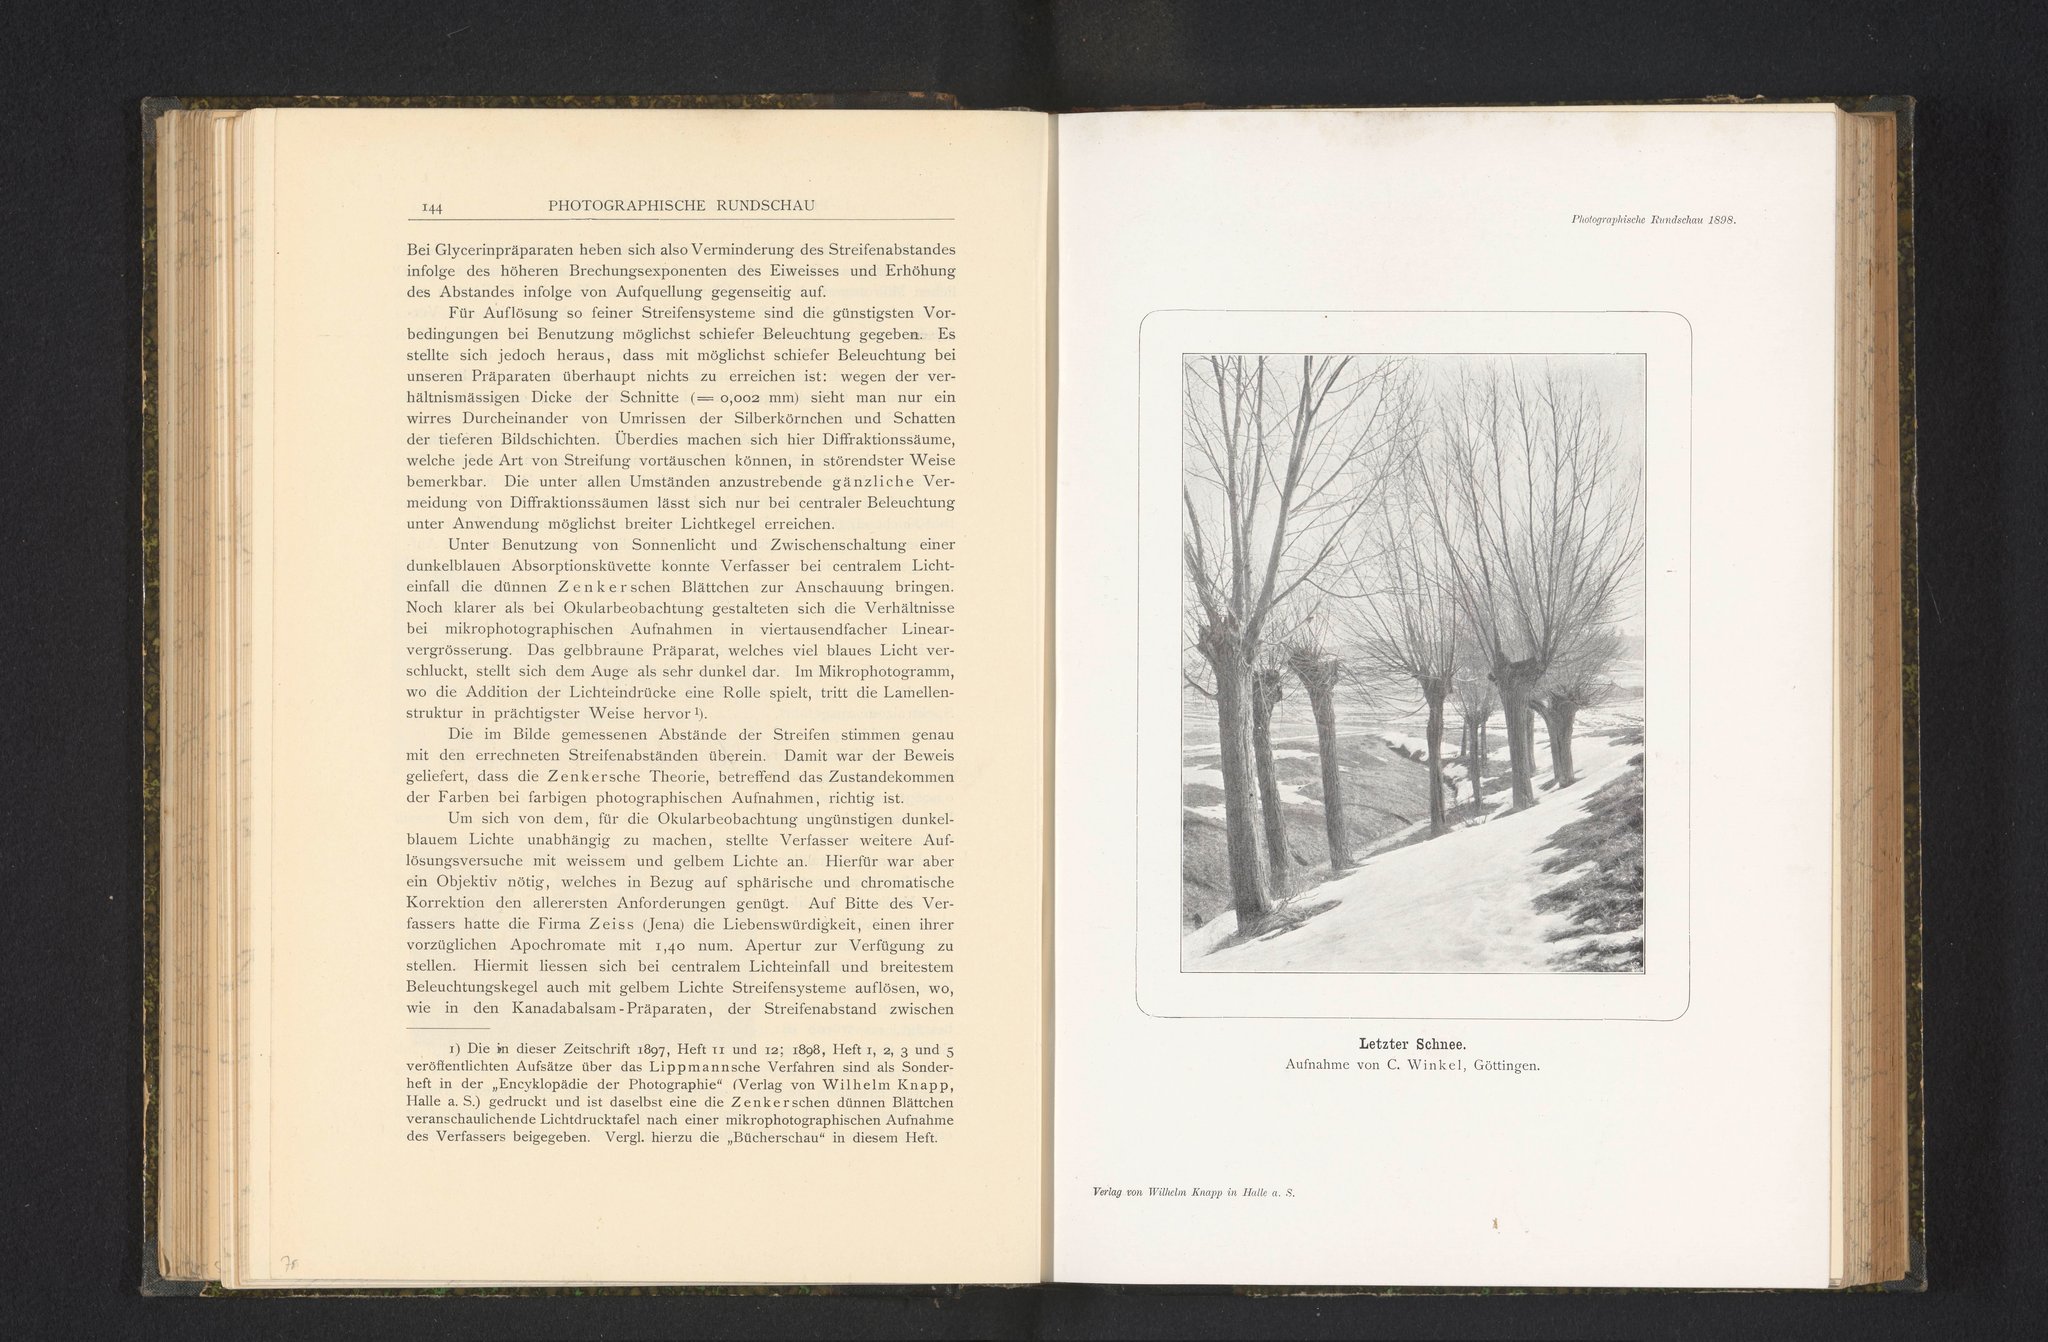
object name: page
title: Knotwilgen in de sneeuw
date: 1893-1898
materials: paper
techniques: autotype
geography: gottingen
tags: winter landscape; landscape symbolizing winter (the four seasons of the year), trees: willow